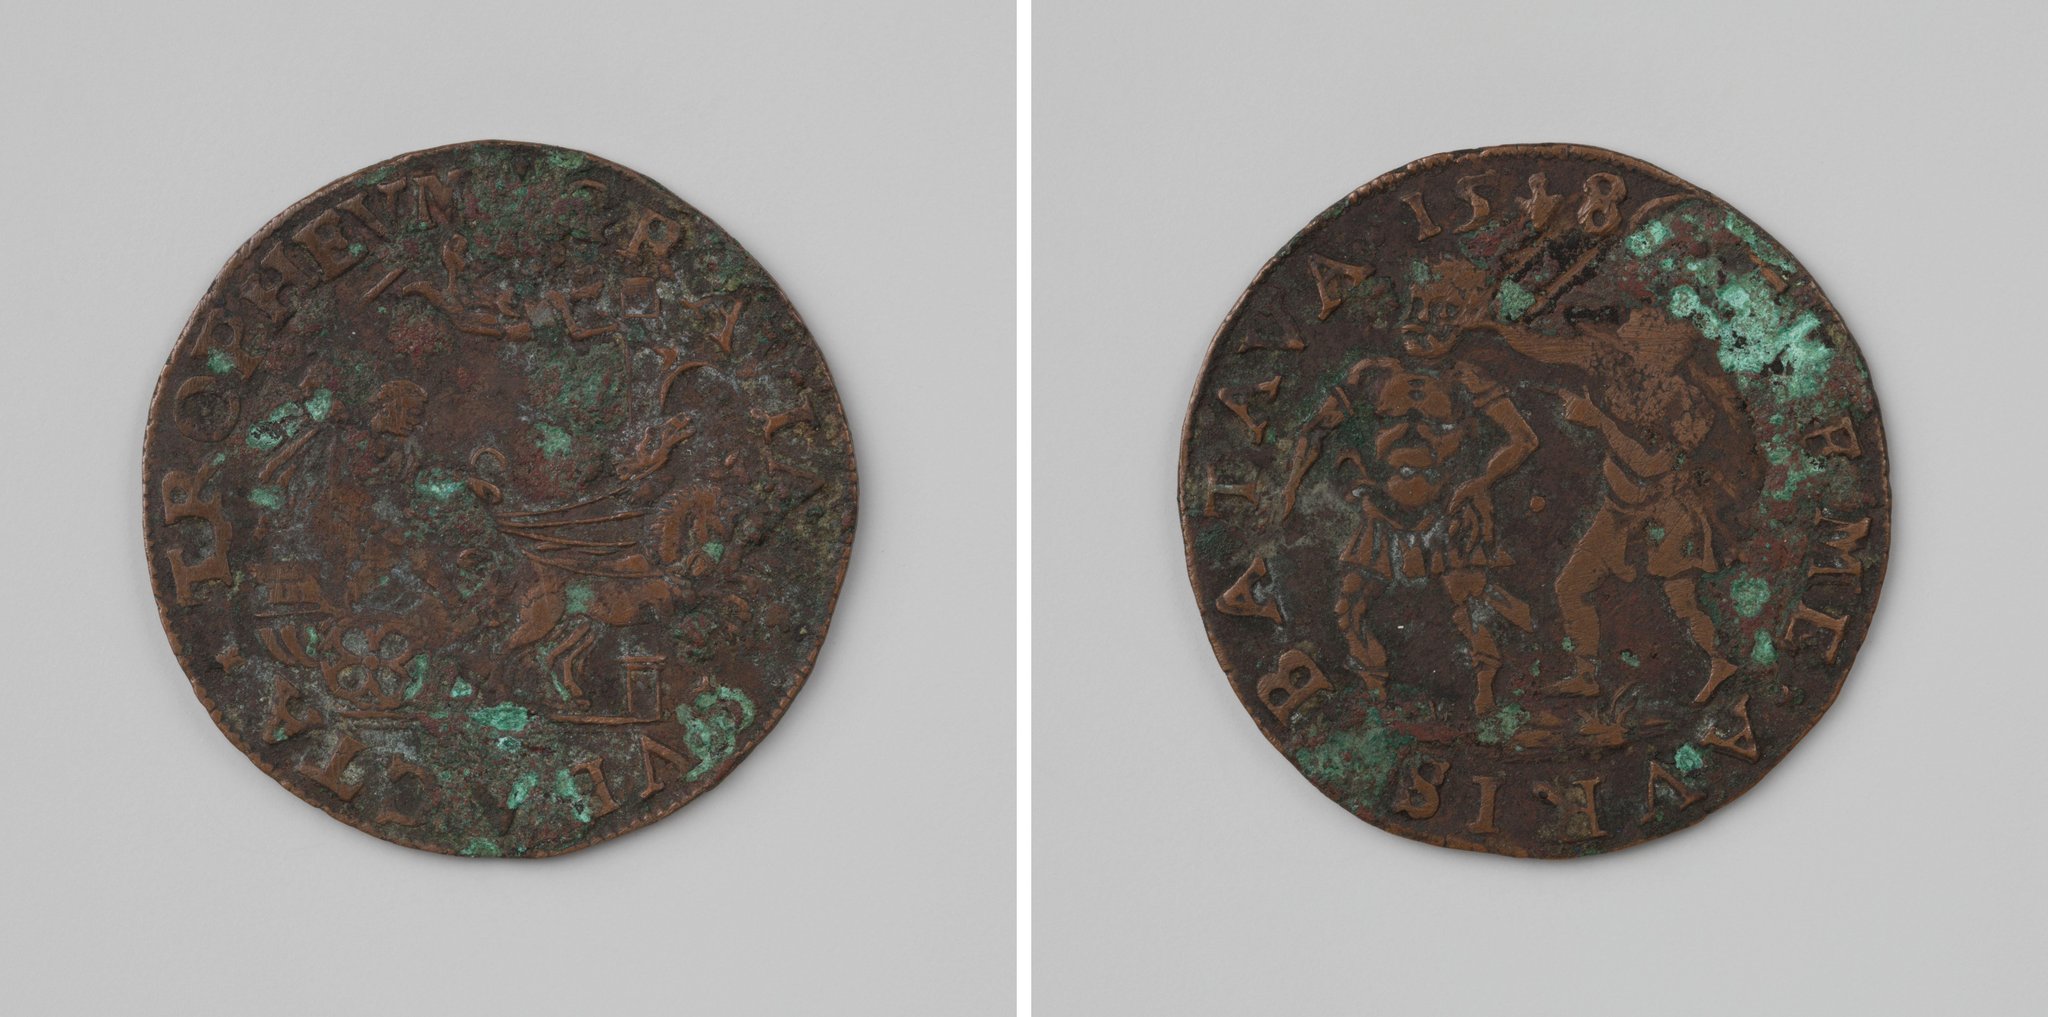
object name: jeton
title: Inname van Grave door Alessandro Farnese, hertog van Parma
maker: Anonymous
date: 1586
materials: copper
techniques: striking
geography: bruges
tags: vienna, albert casimir van saksen-teschen, rome, alessandro farnese (landvoogd van de nederlanden en hertog van parma en piacenza), grave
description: Koperen penning. Voorzijde: hertog van Parma met zweep in handen, staande op vierspan; daarboven Faam, blazend op bazuin binnen omschrift. Keerzijde: Spanjaard trekt Nederlander aan zijn oor binnen omschrift